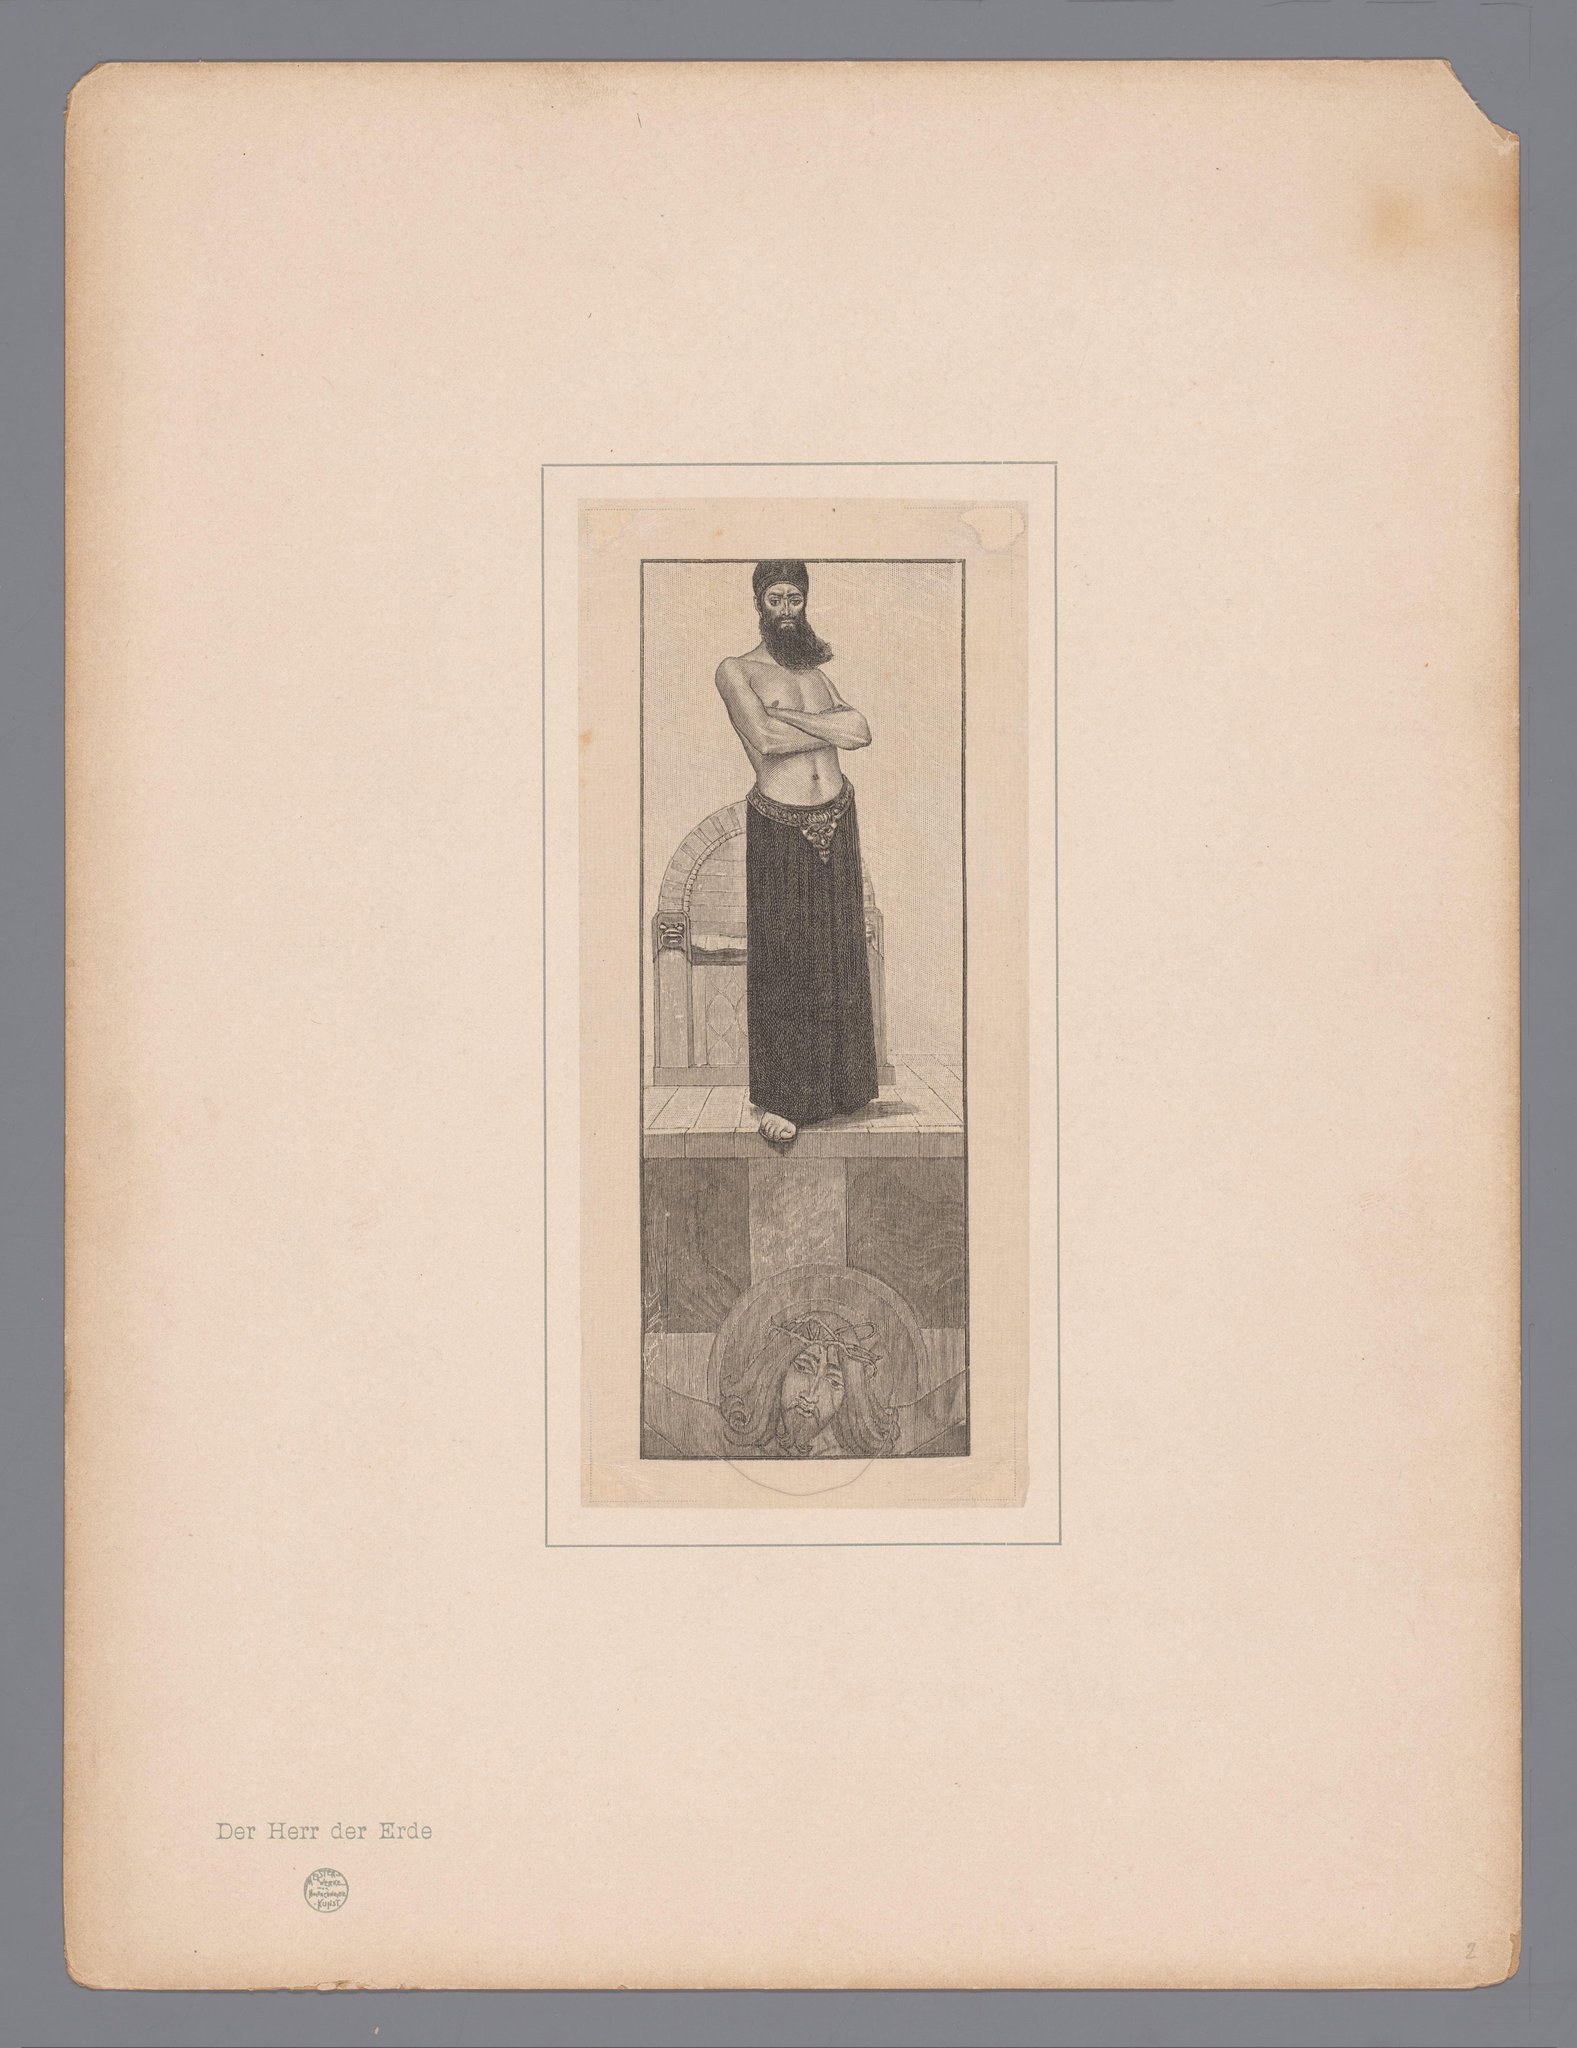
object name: print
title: Man met baard voor een troon boven Christus aan het kruis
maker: johann jakob weber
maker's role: publisher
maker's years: 1803-1880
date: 1813-1880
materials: paper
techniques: lithograph, engraving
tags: other types of crucified christ in non-narrative context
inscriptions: collector's mark: Lugt 2228